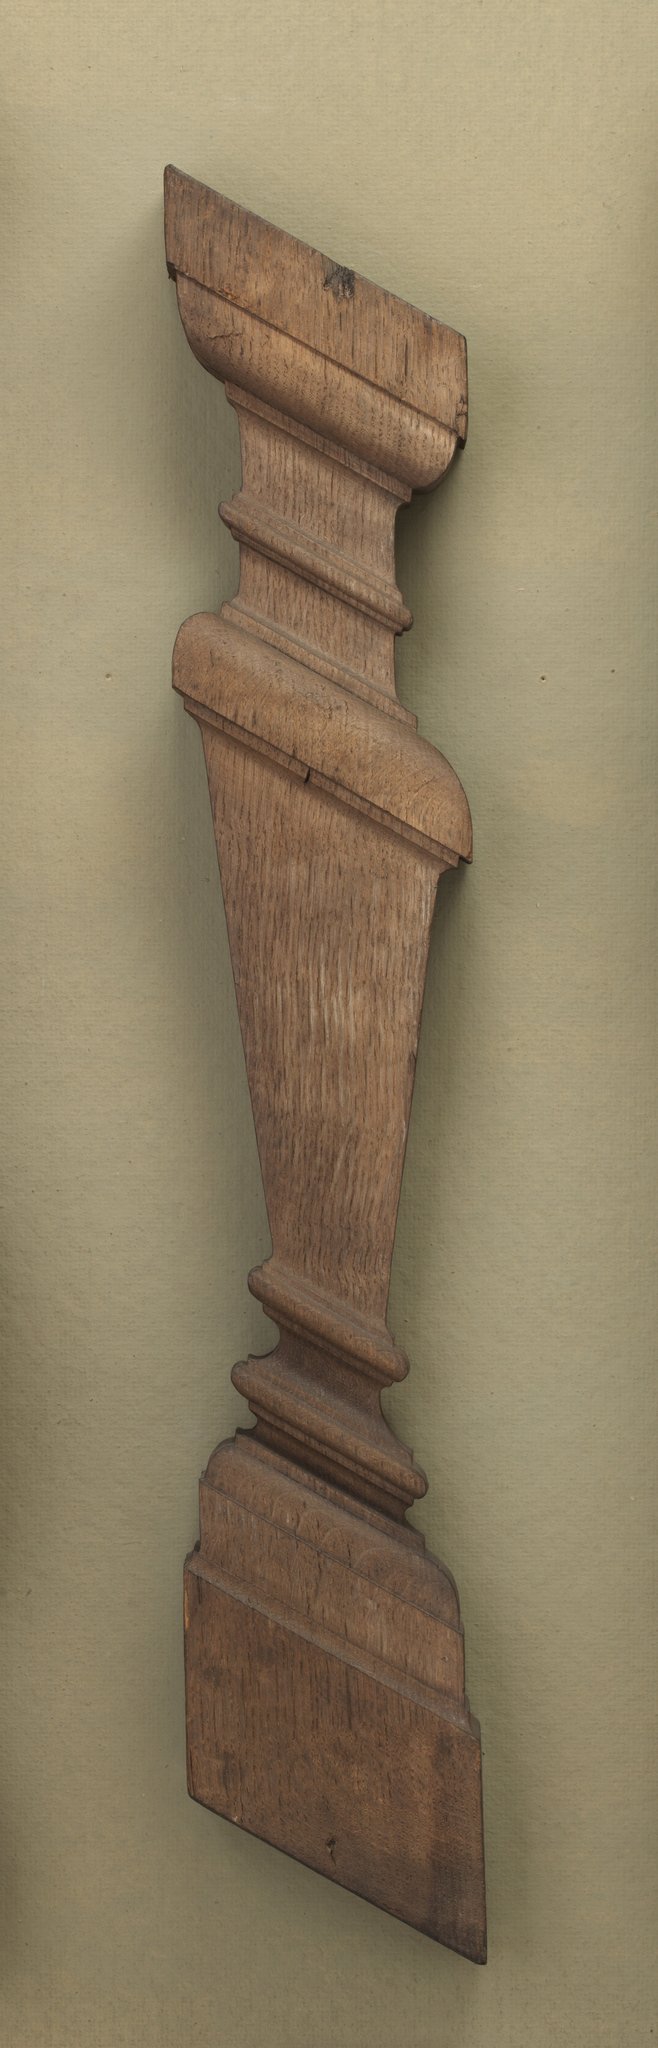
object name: baluster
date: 1601-1650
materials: wood